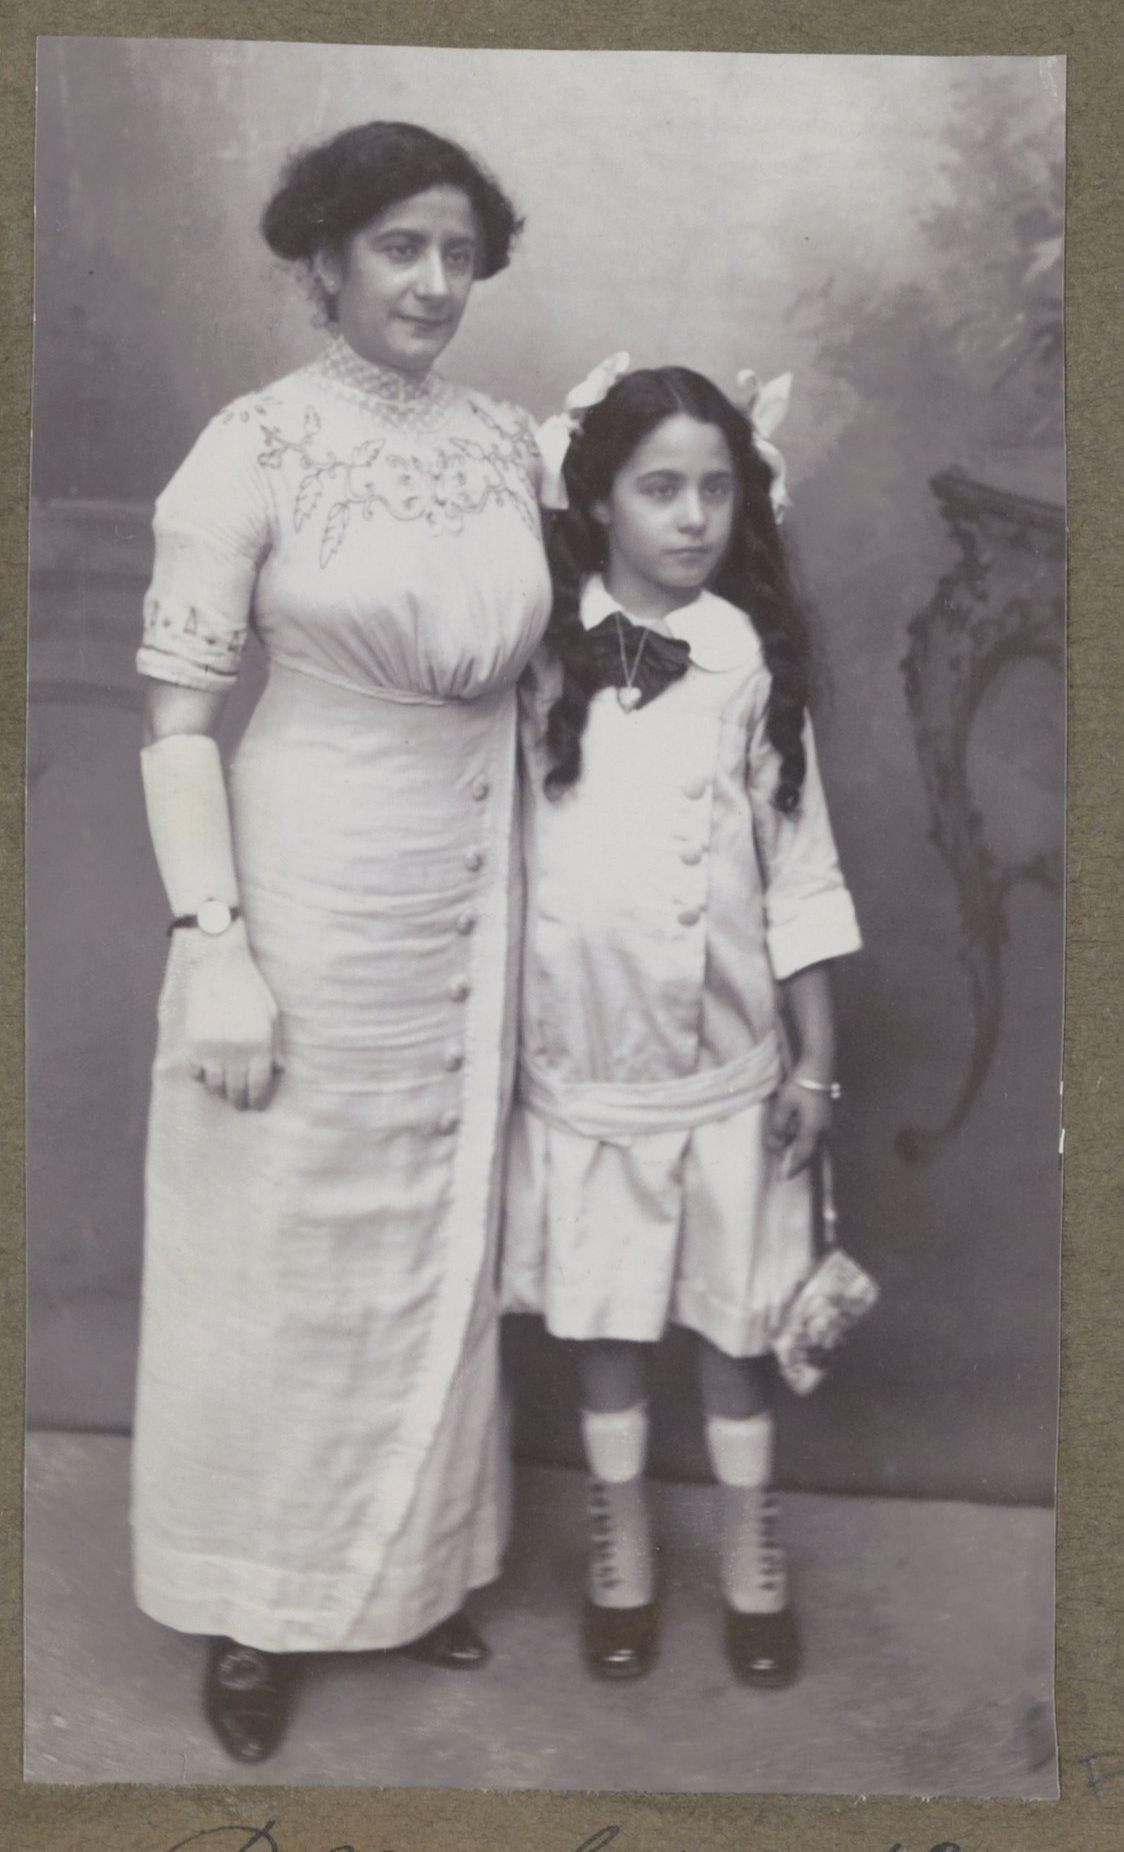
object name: photograph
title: Portret van een vrouw en een jong meisje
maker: Anonymous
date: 1912-1913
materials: photographic support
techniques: gelatin silver print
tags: studio requisites ~ photographer, mother and baby or young child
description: Onderdeel van fotoalbum van een onbekende Nederlandse familie met opnames van Suriname, Europa en Nederlands-Indië.